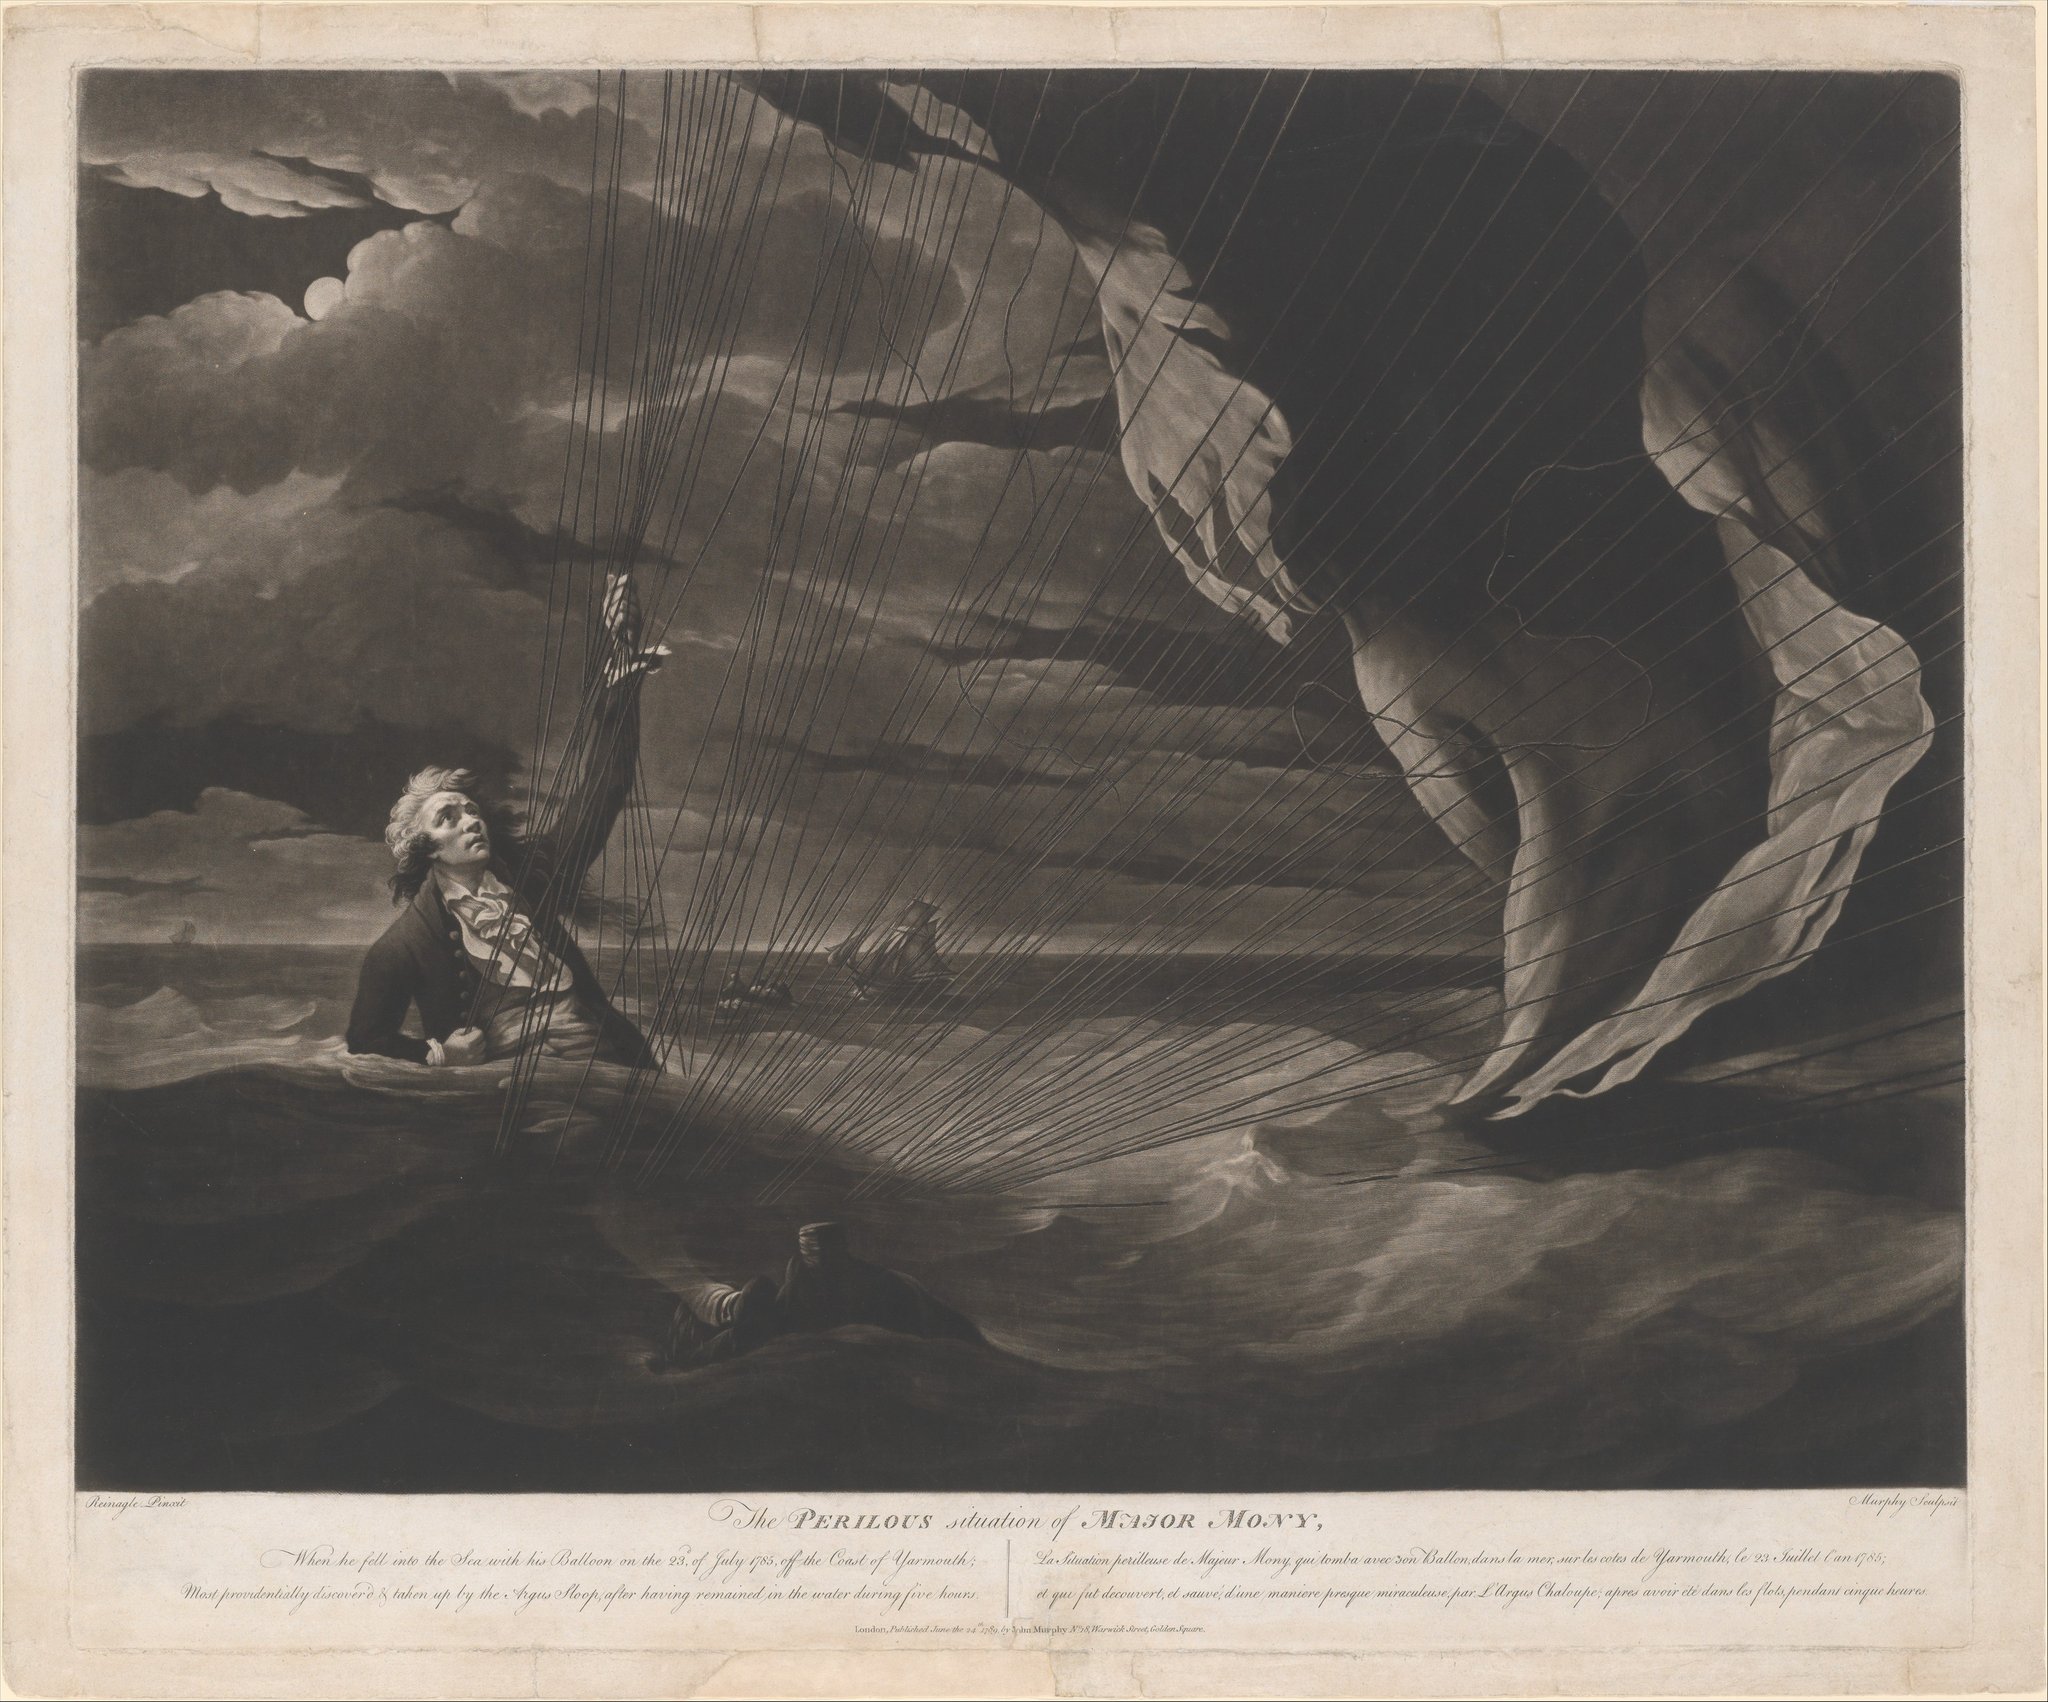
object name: print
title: The Perilous Situation of Major Mony, When He Fell into the Sea with His Balloon on the 23rd of July, 1785, Off the Coast of Yarmouth; Most Providentially Discovered and Taken Up by the Argus Sloop, After Having Remained in the Water During Five Hours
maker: john murphy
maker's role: engraver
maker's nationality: irish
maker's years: 1778-1817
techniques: mezzotint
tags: men,seas,hot air balloons